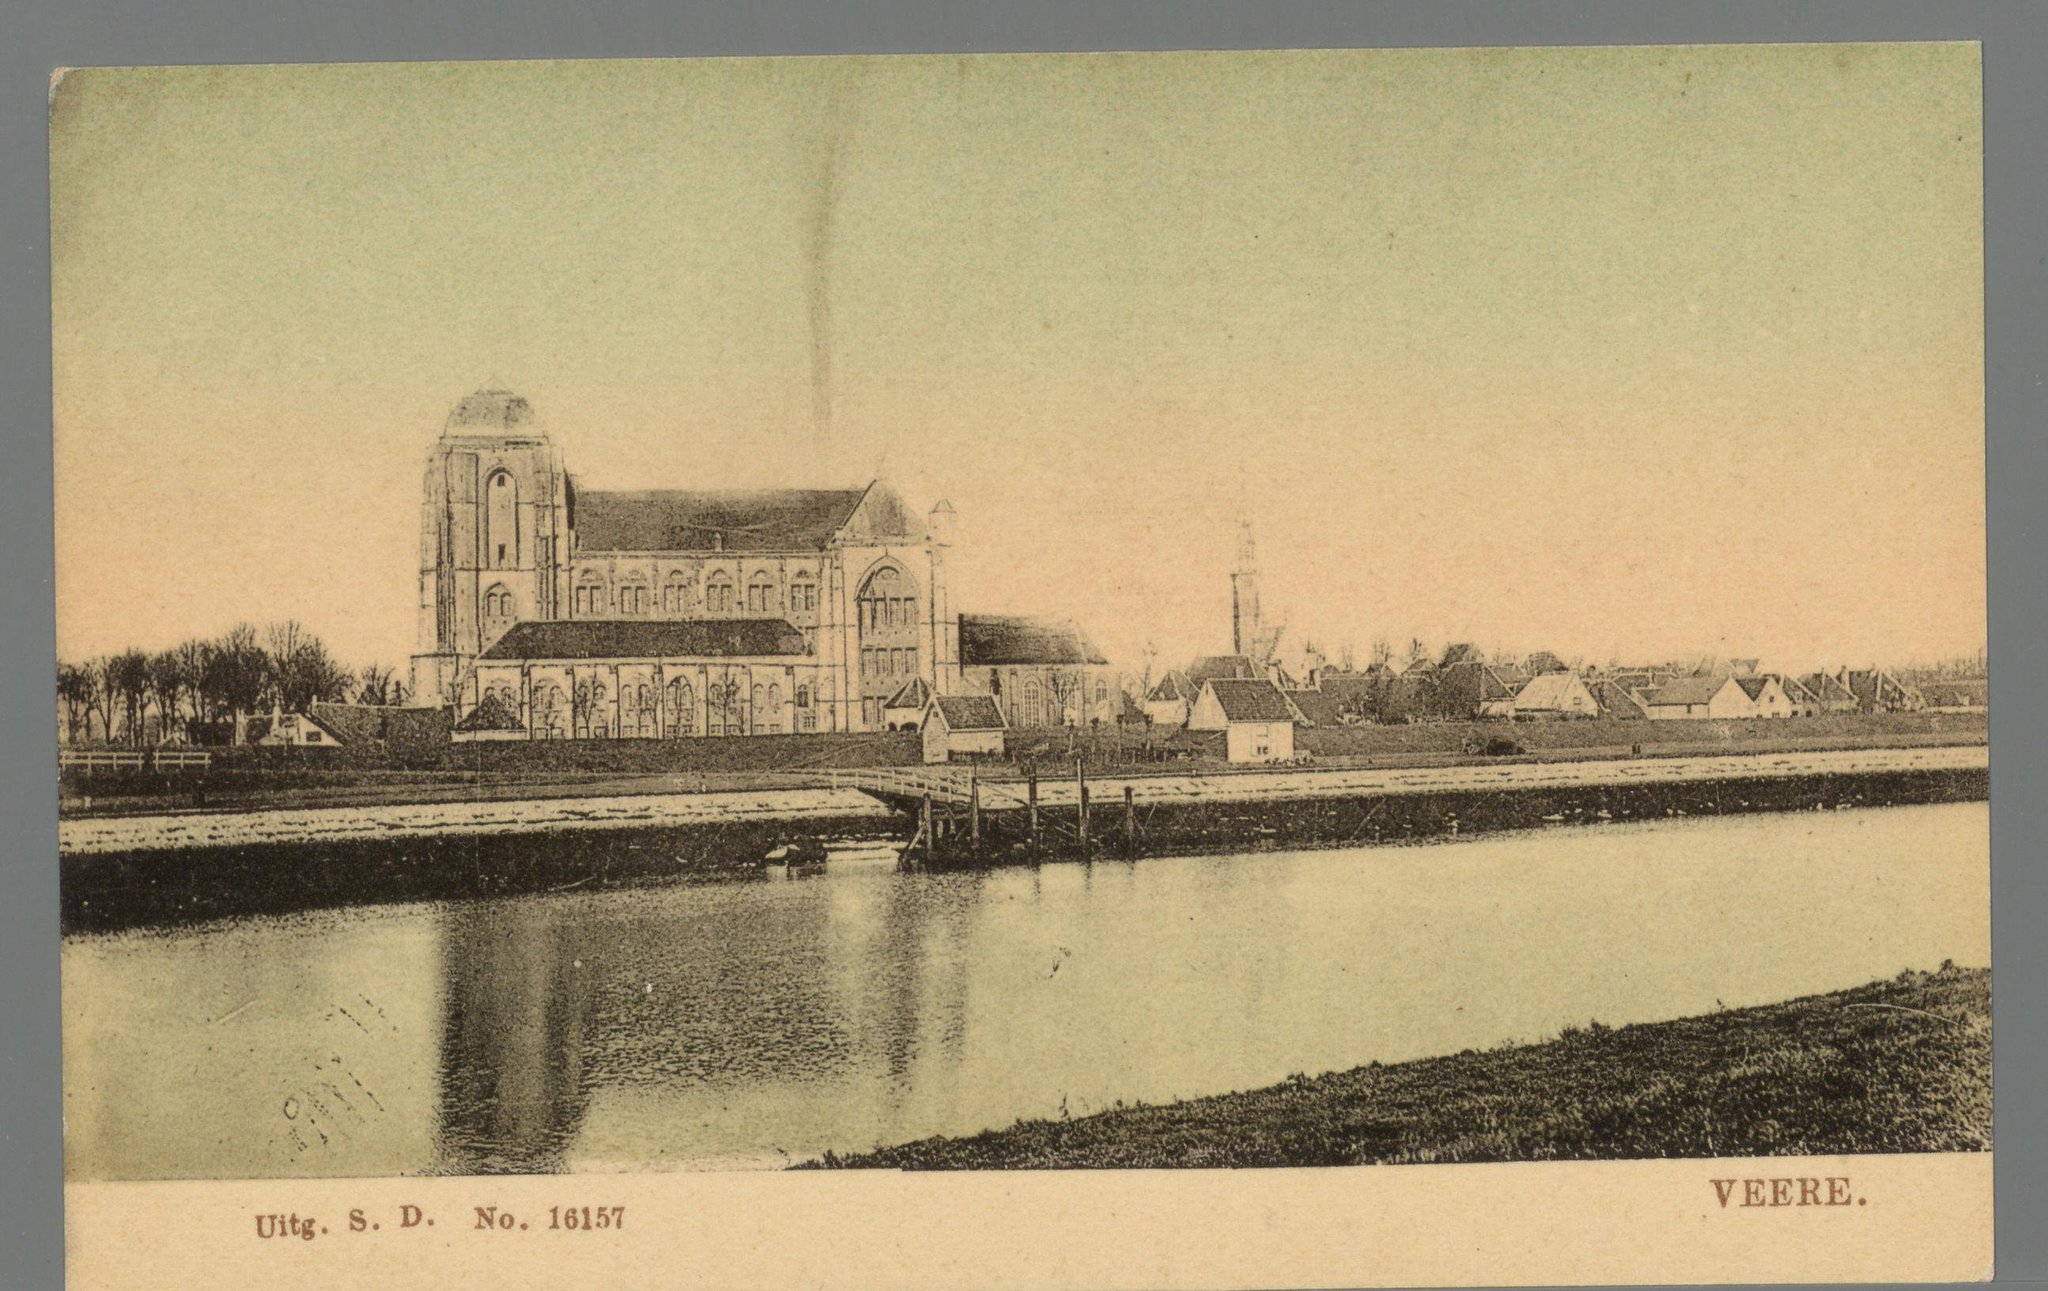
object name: photomechanical print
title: Veere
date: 1905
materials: cardboard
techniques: photograph, iris print, lithograph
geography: veere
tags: city-view, and landscape with man-made constructions, church (exterior), townhall, canals, waters (in city)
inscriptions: monogram: ‘S.D.’